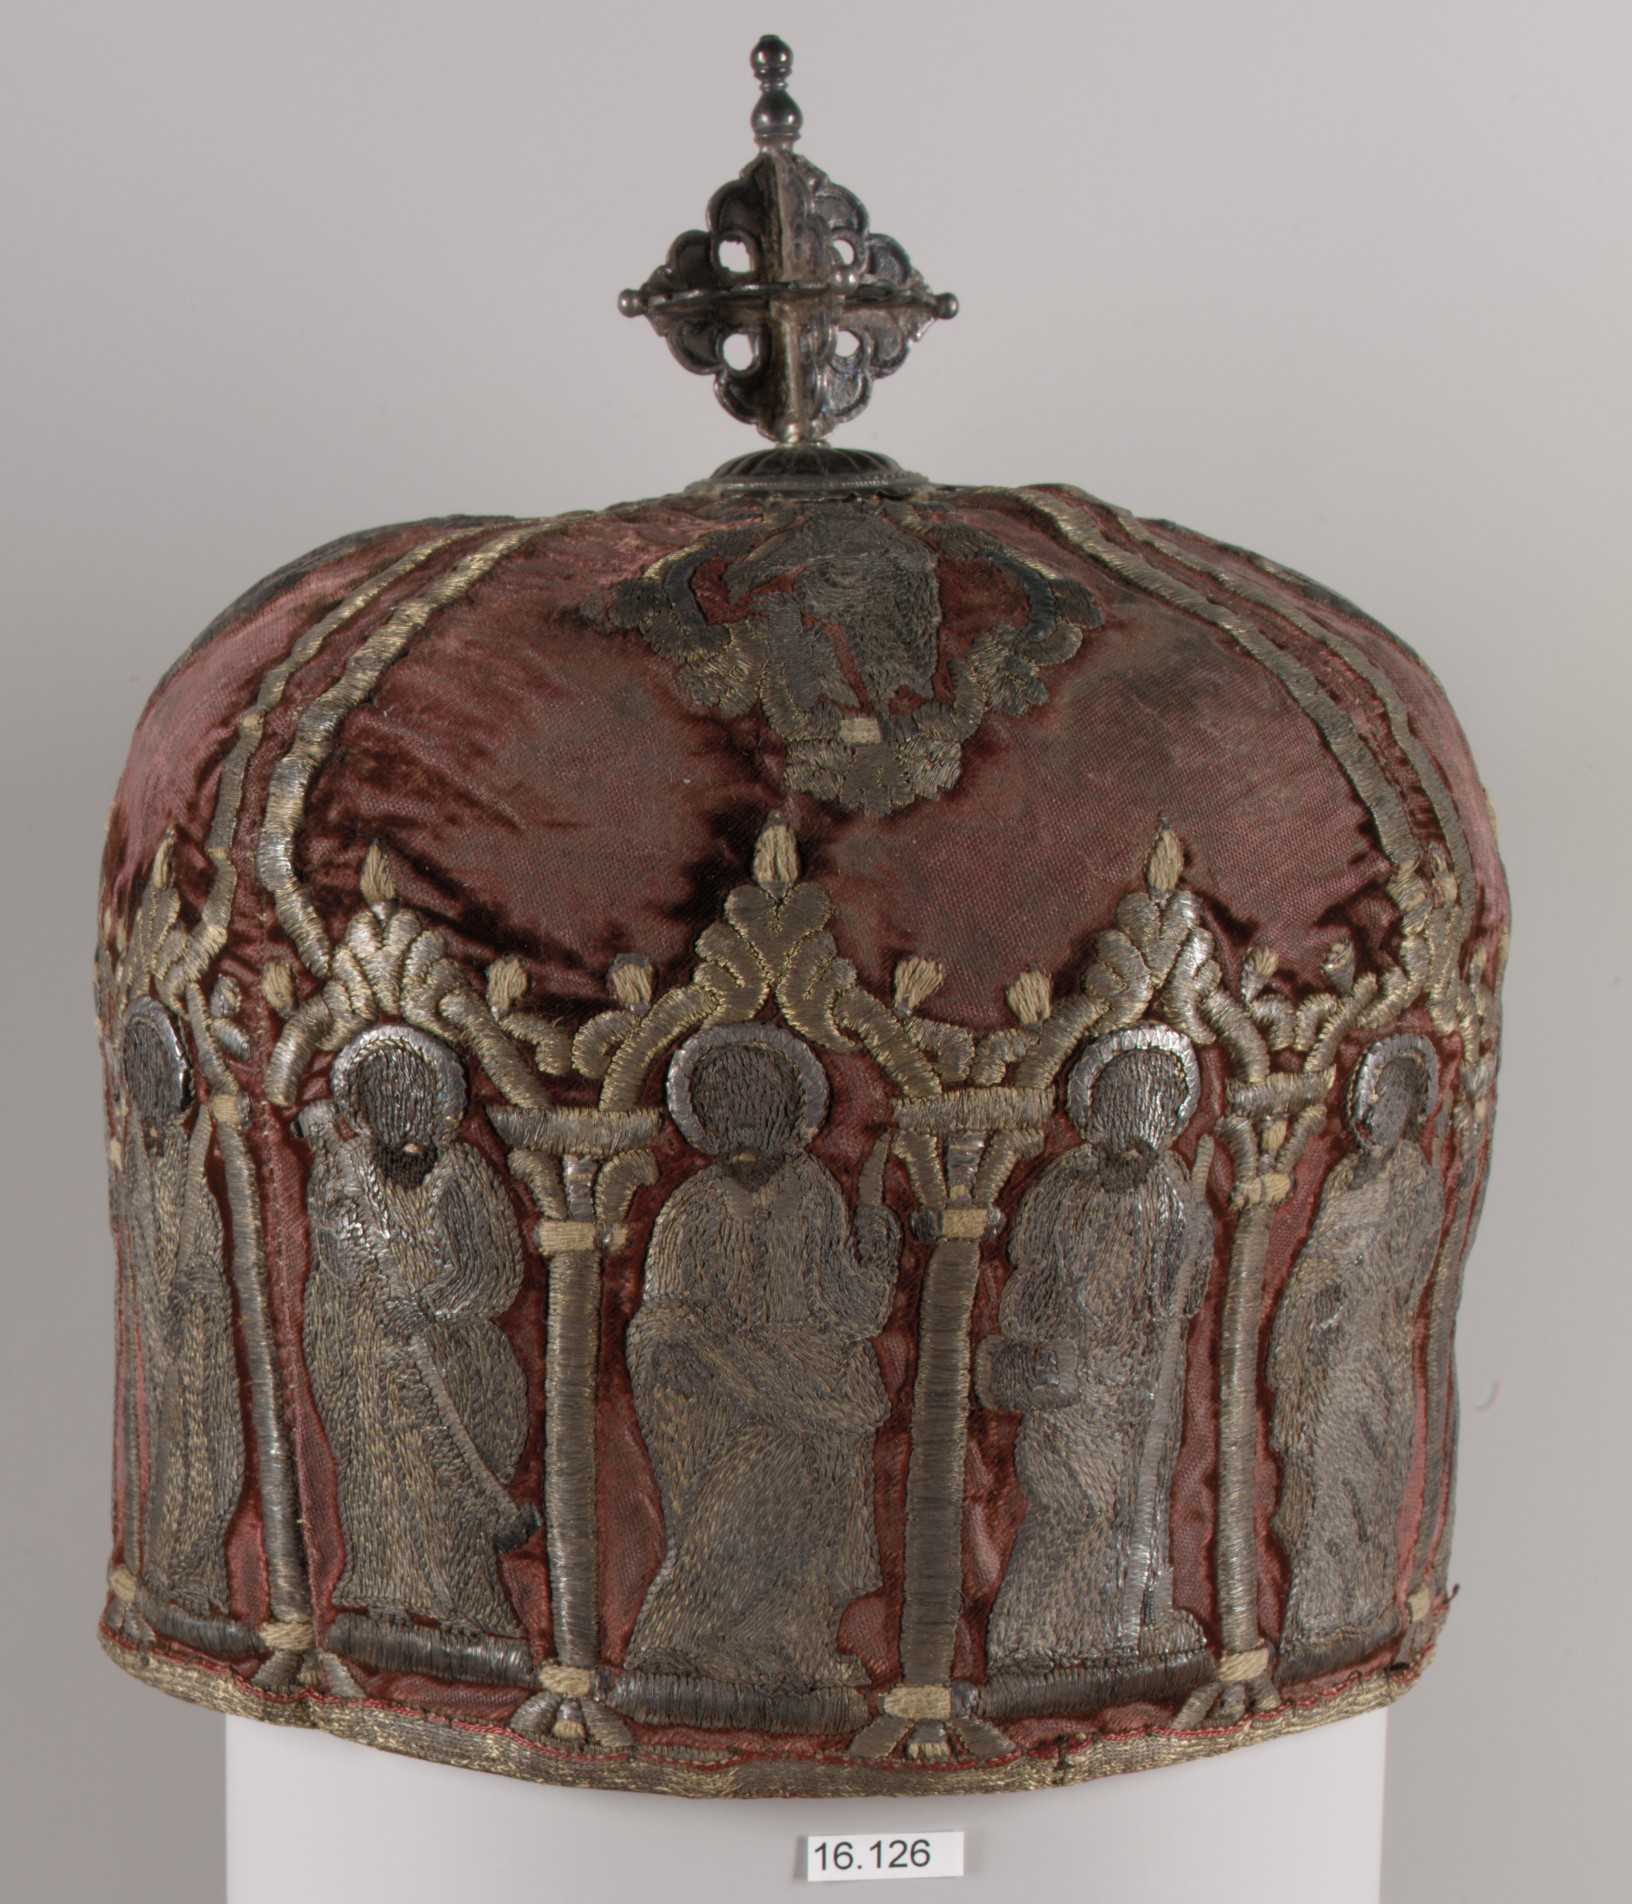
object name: miter for a priest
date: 1601-1700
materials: gold, silver, velvet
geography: armenia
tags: apostles,christ